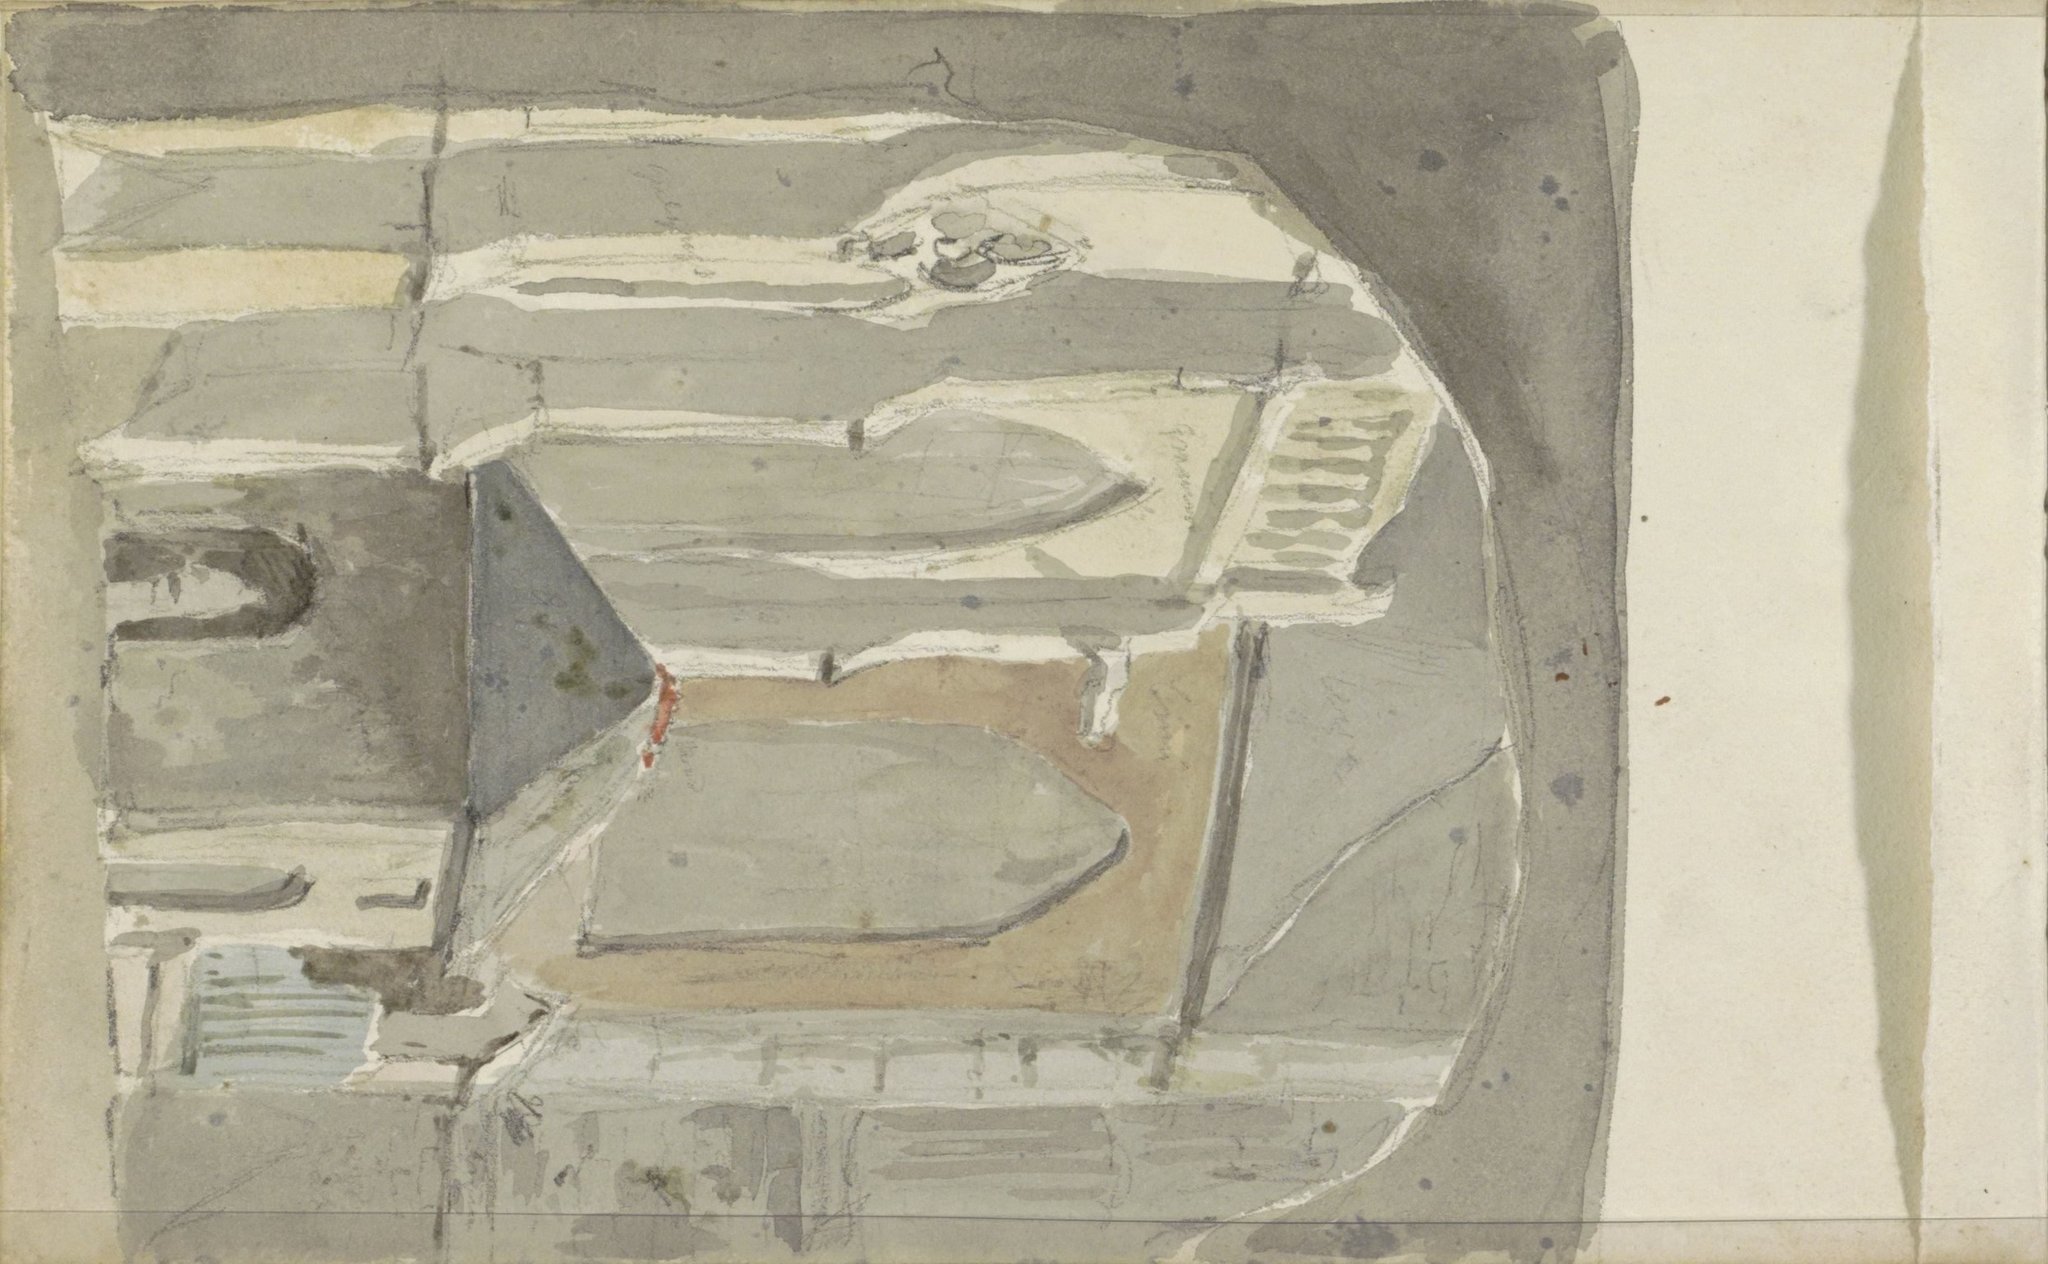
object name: sketchbook leaf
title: Gezicht op een kerk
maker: adrianus eversen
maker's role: draughtsman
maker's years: 1818-1897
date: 1828-1897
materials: paper, pencil, watercolor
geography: netherlands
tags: church (exterior)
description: Gezicht op een kerk, vanonder een boog gezien. In het midden een aanbouw met een vierkante plattegrond. Blad 16 verso uit een schetsboek met 27 bladen.